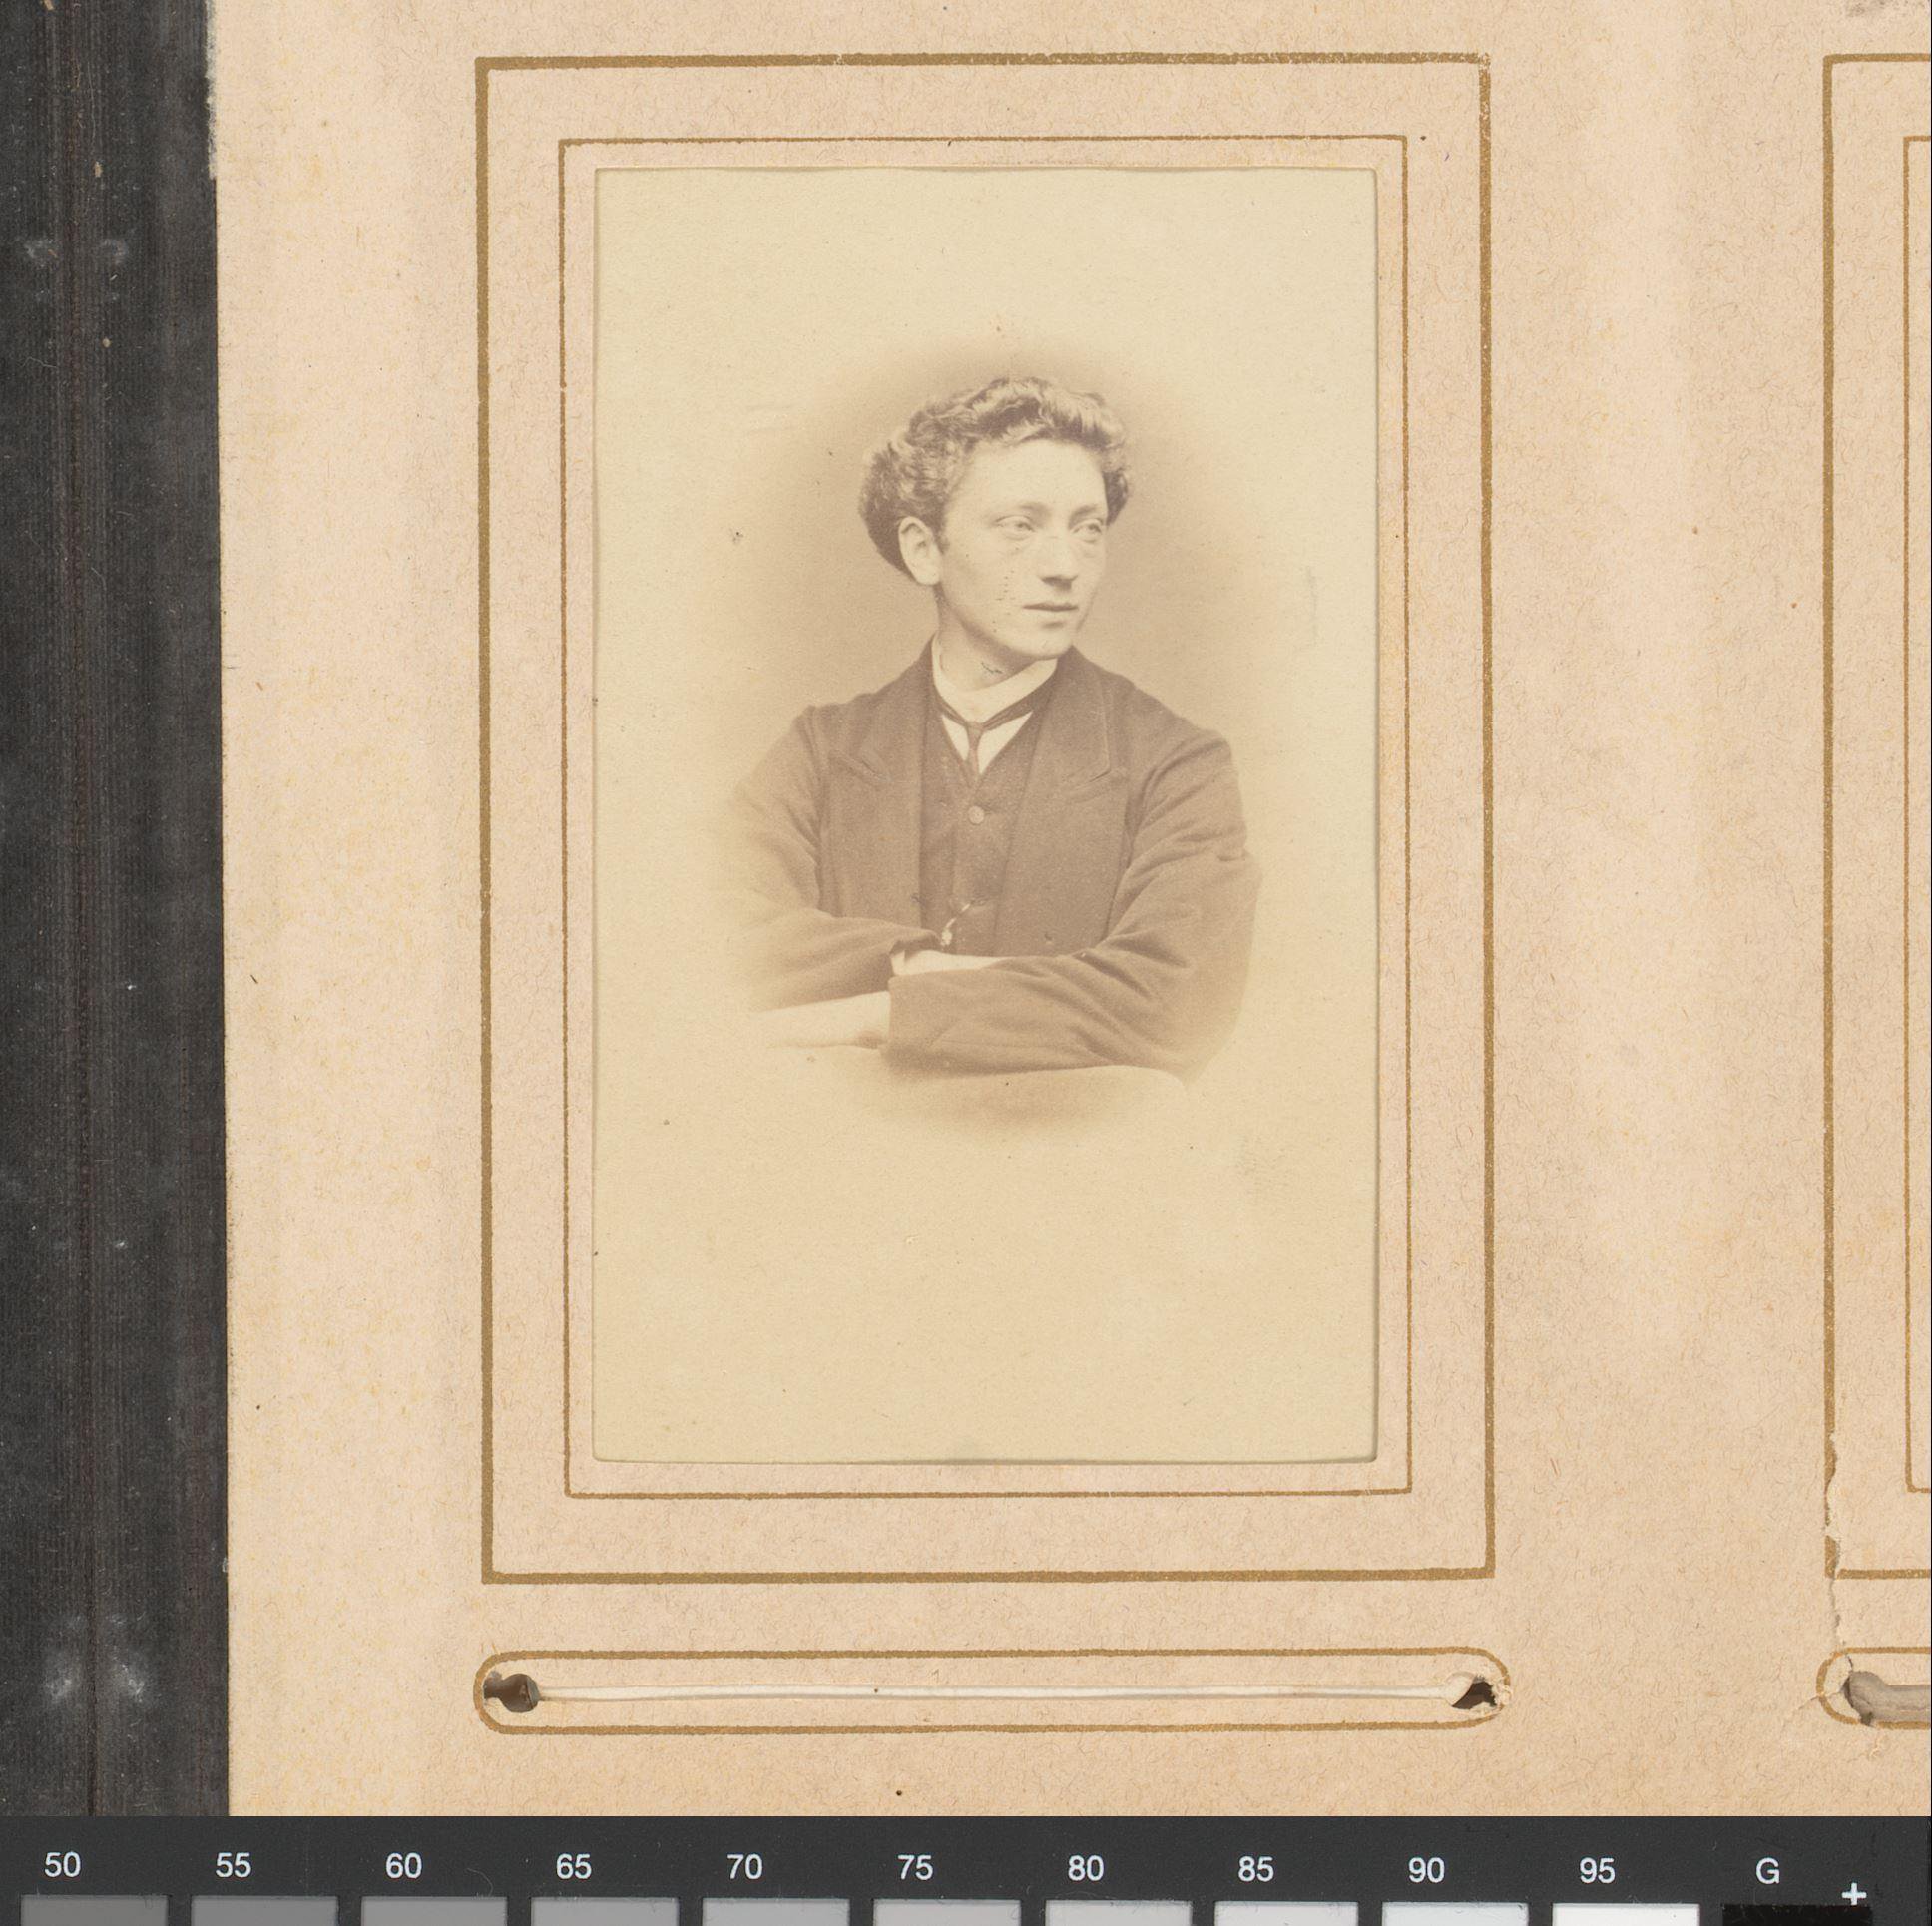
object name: photograph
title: Portret van een jongeman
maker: albert greiner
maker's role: fotograaf, fotostudio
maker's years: 1833-1890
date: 1861-1874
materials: cardboard, photographic support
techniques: albumen print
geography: amsterdam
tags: adolescent, young woman, maiden, historical persons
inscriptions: inscription: ‘A. Greiner/ Photograf/ Nieuwendijk L.87/ Amsterdam’